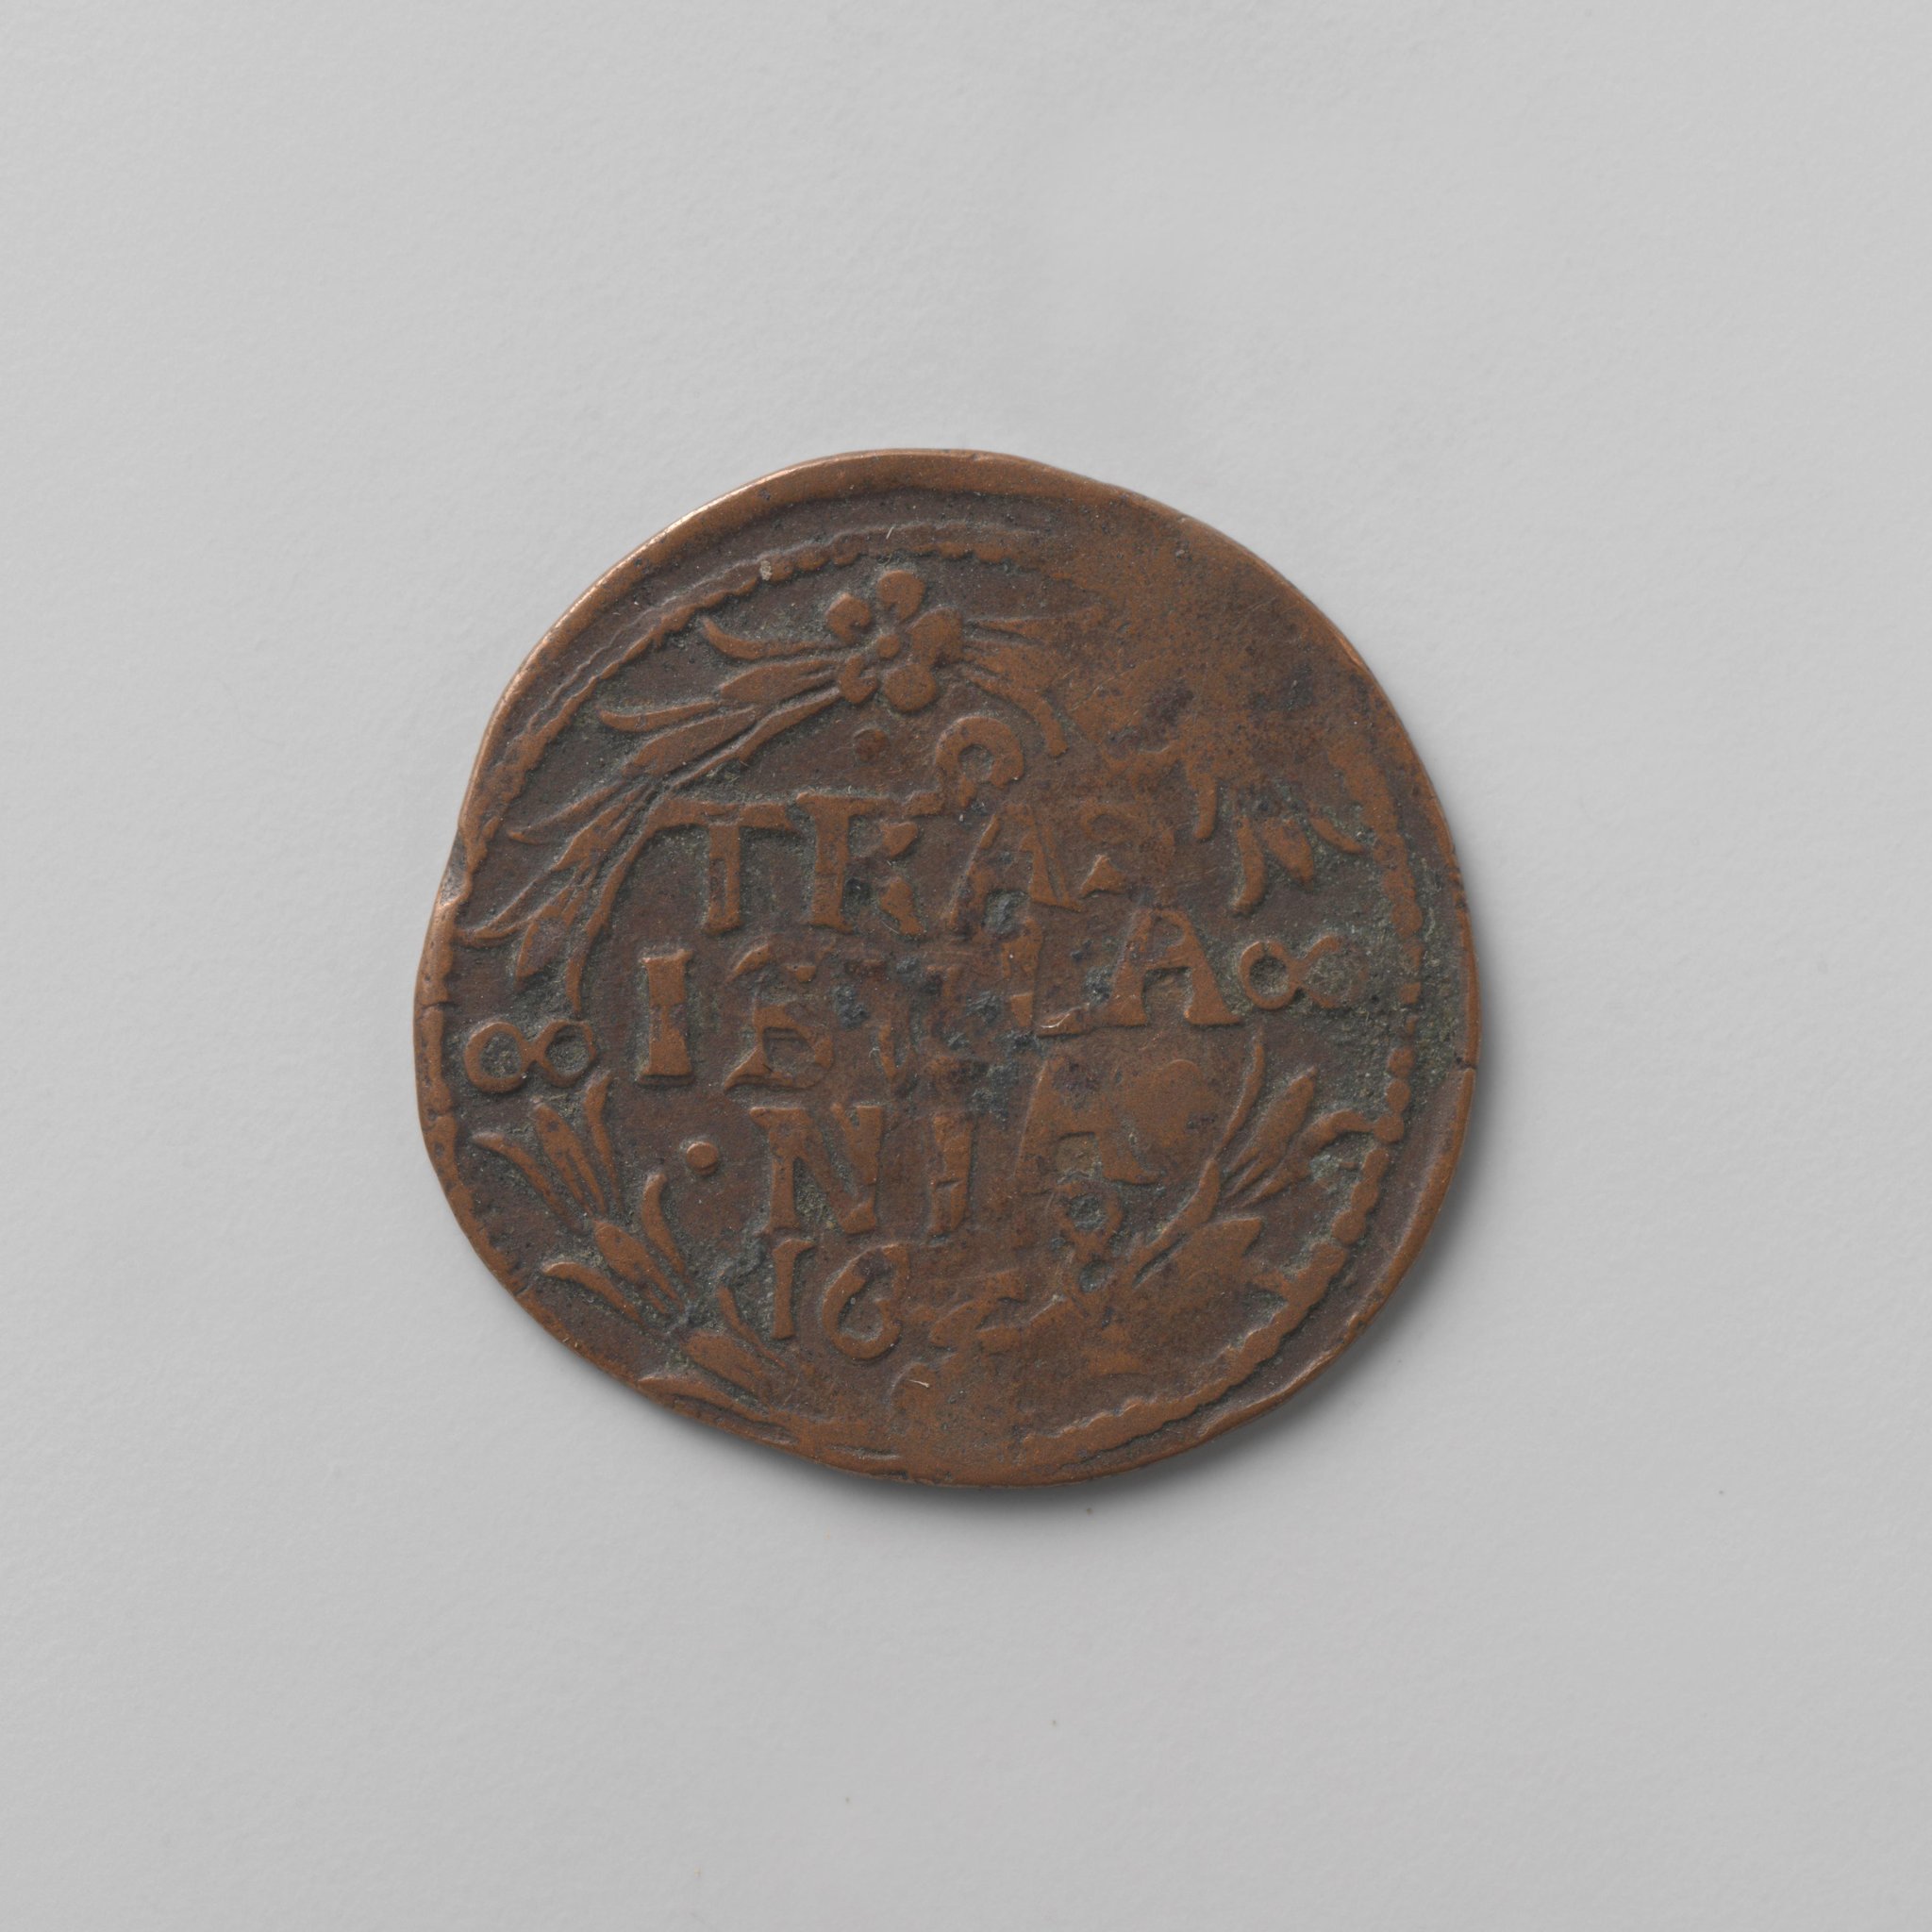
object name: coin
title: Overijssel, duit, 1628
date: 1628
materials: copper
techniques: striking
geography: kampen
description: Zilveren munt. Voorzijde: binnen lauwerkrans drieregelig opschrift, waaronder jaartal. Keerzijde: binnen lauwerkrans gekroond provinciaal wapenschild.